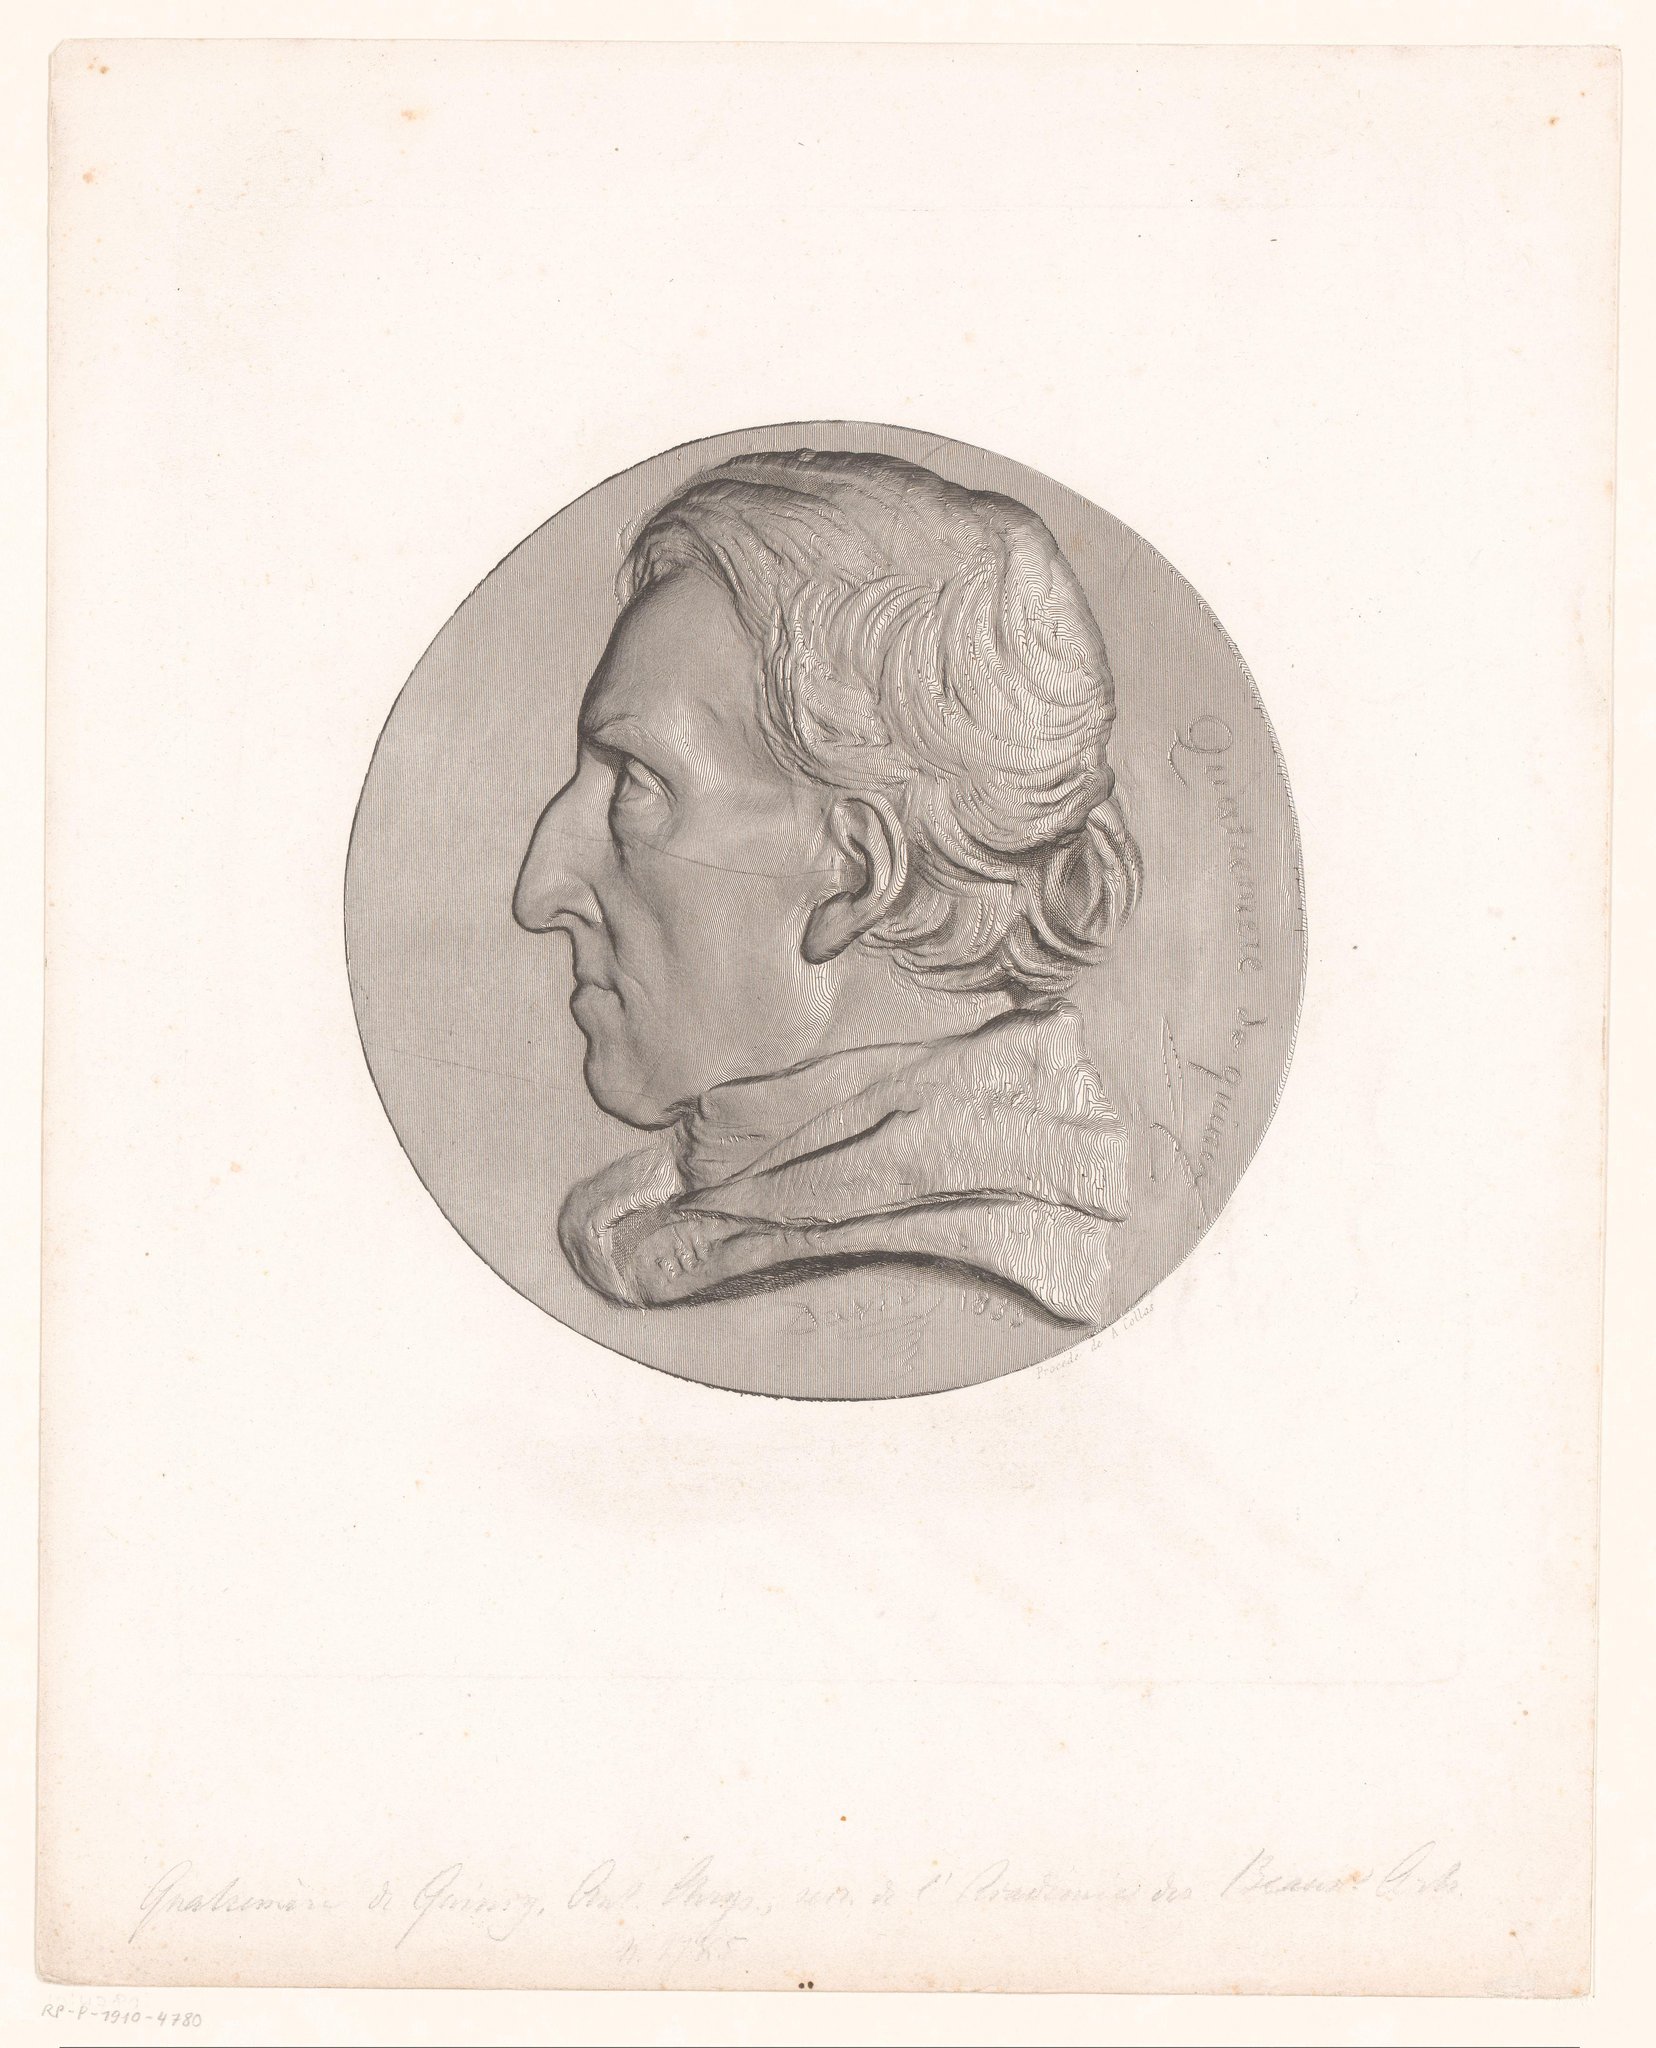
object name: print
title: Quatremere de quiney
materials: paper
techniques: relief engraving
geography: france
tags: paris, ornament ~ medallion, historical persons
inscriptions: collector's mark: Lugt 2228